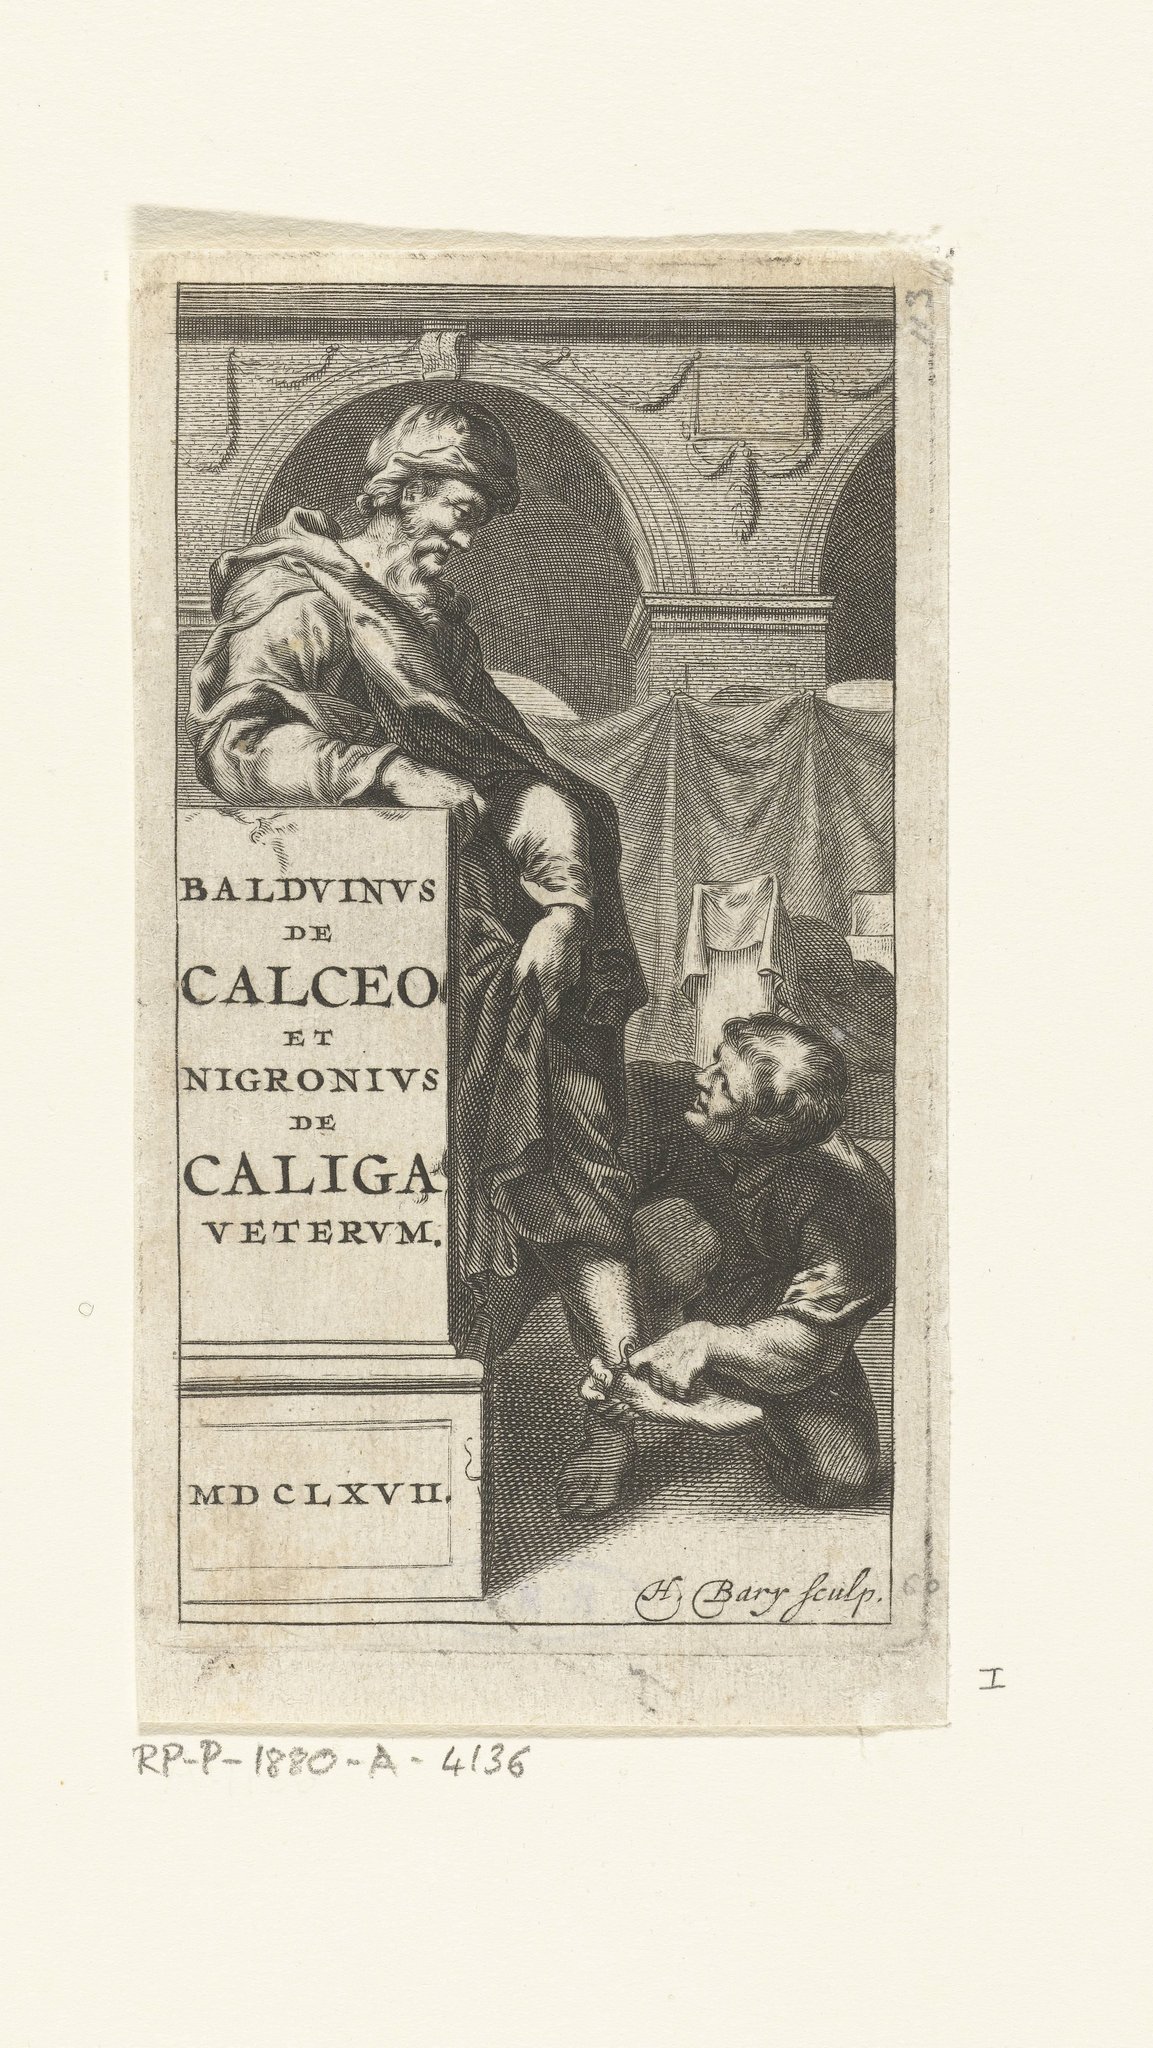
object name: print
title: Een bediende trekt zijn heer een schoen aan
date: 1667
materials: paper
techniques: engraving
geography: amsterdam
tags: putting on (tying) or taking off (untying) sandals or shoes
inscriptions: collector's mark: Lugt 2228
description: Titelpagina voor: B. Balduinus, Calceus antiquus et mysticus; J. Nigronus, De caliga veterum. Amstelodami, sumpt. A. Frisii, 1667